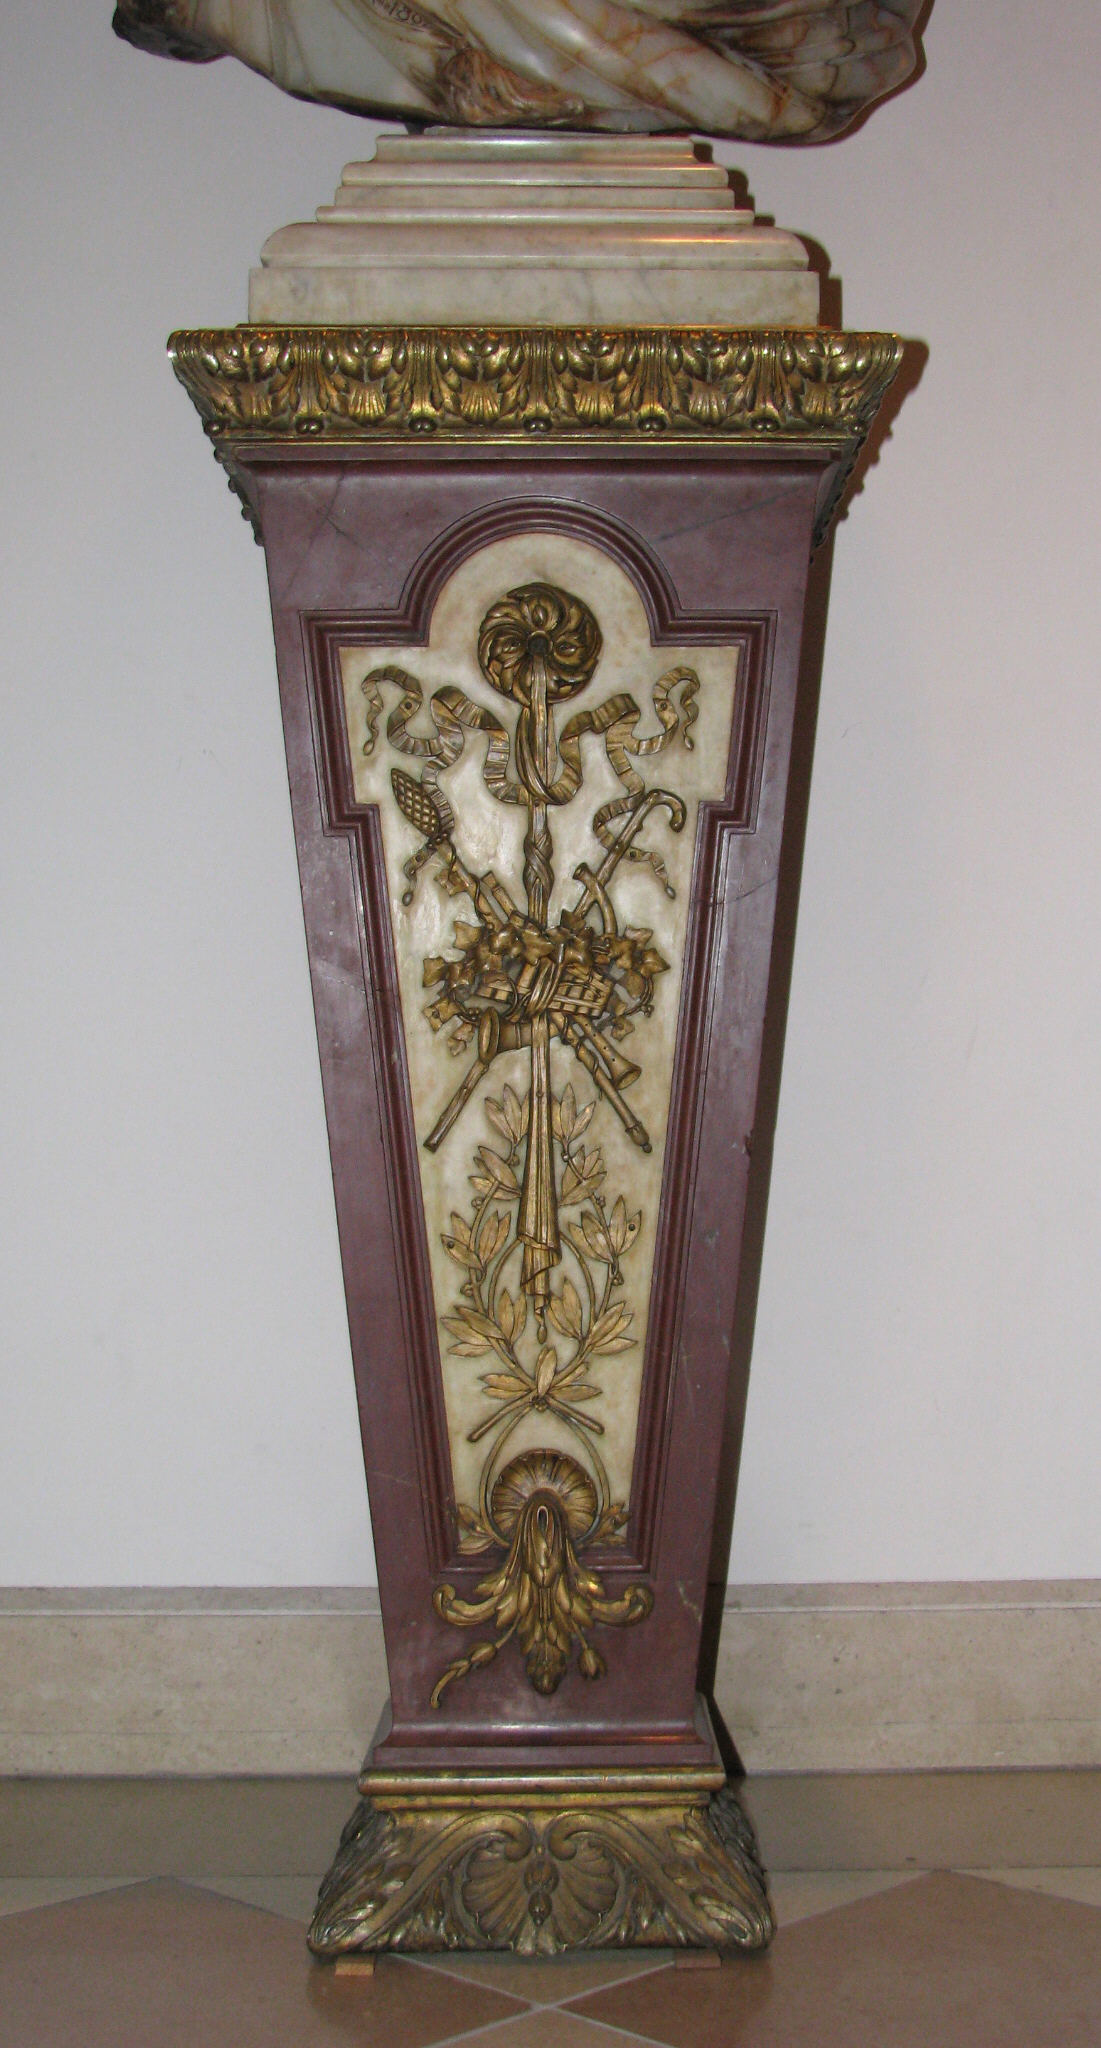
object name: pedestal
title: Pedestal [Woman of Algiers]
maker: charles-henri-joseph cordier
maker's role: artist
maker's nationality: french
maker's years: 1827-1905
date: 1862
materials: gilt bronze, marble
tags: portraits,women